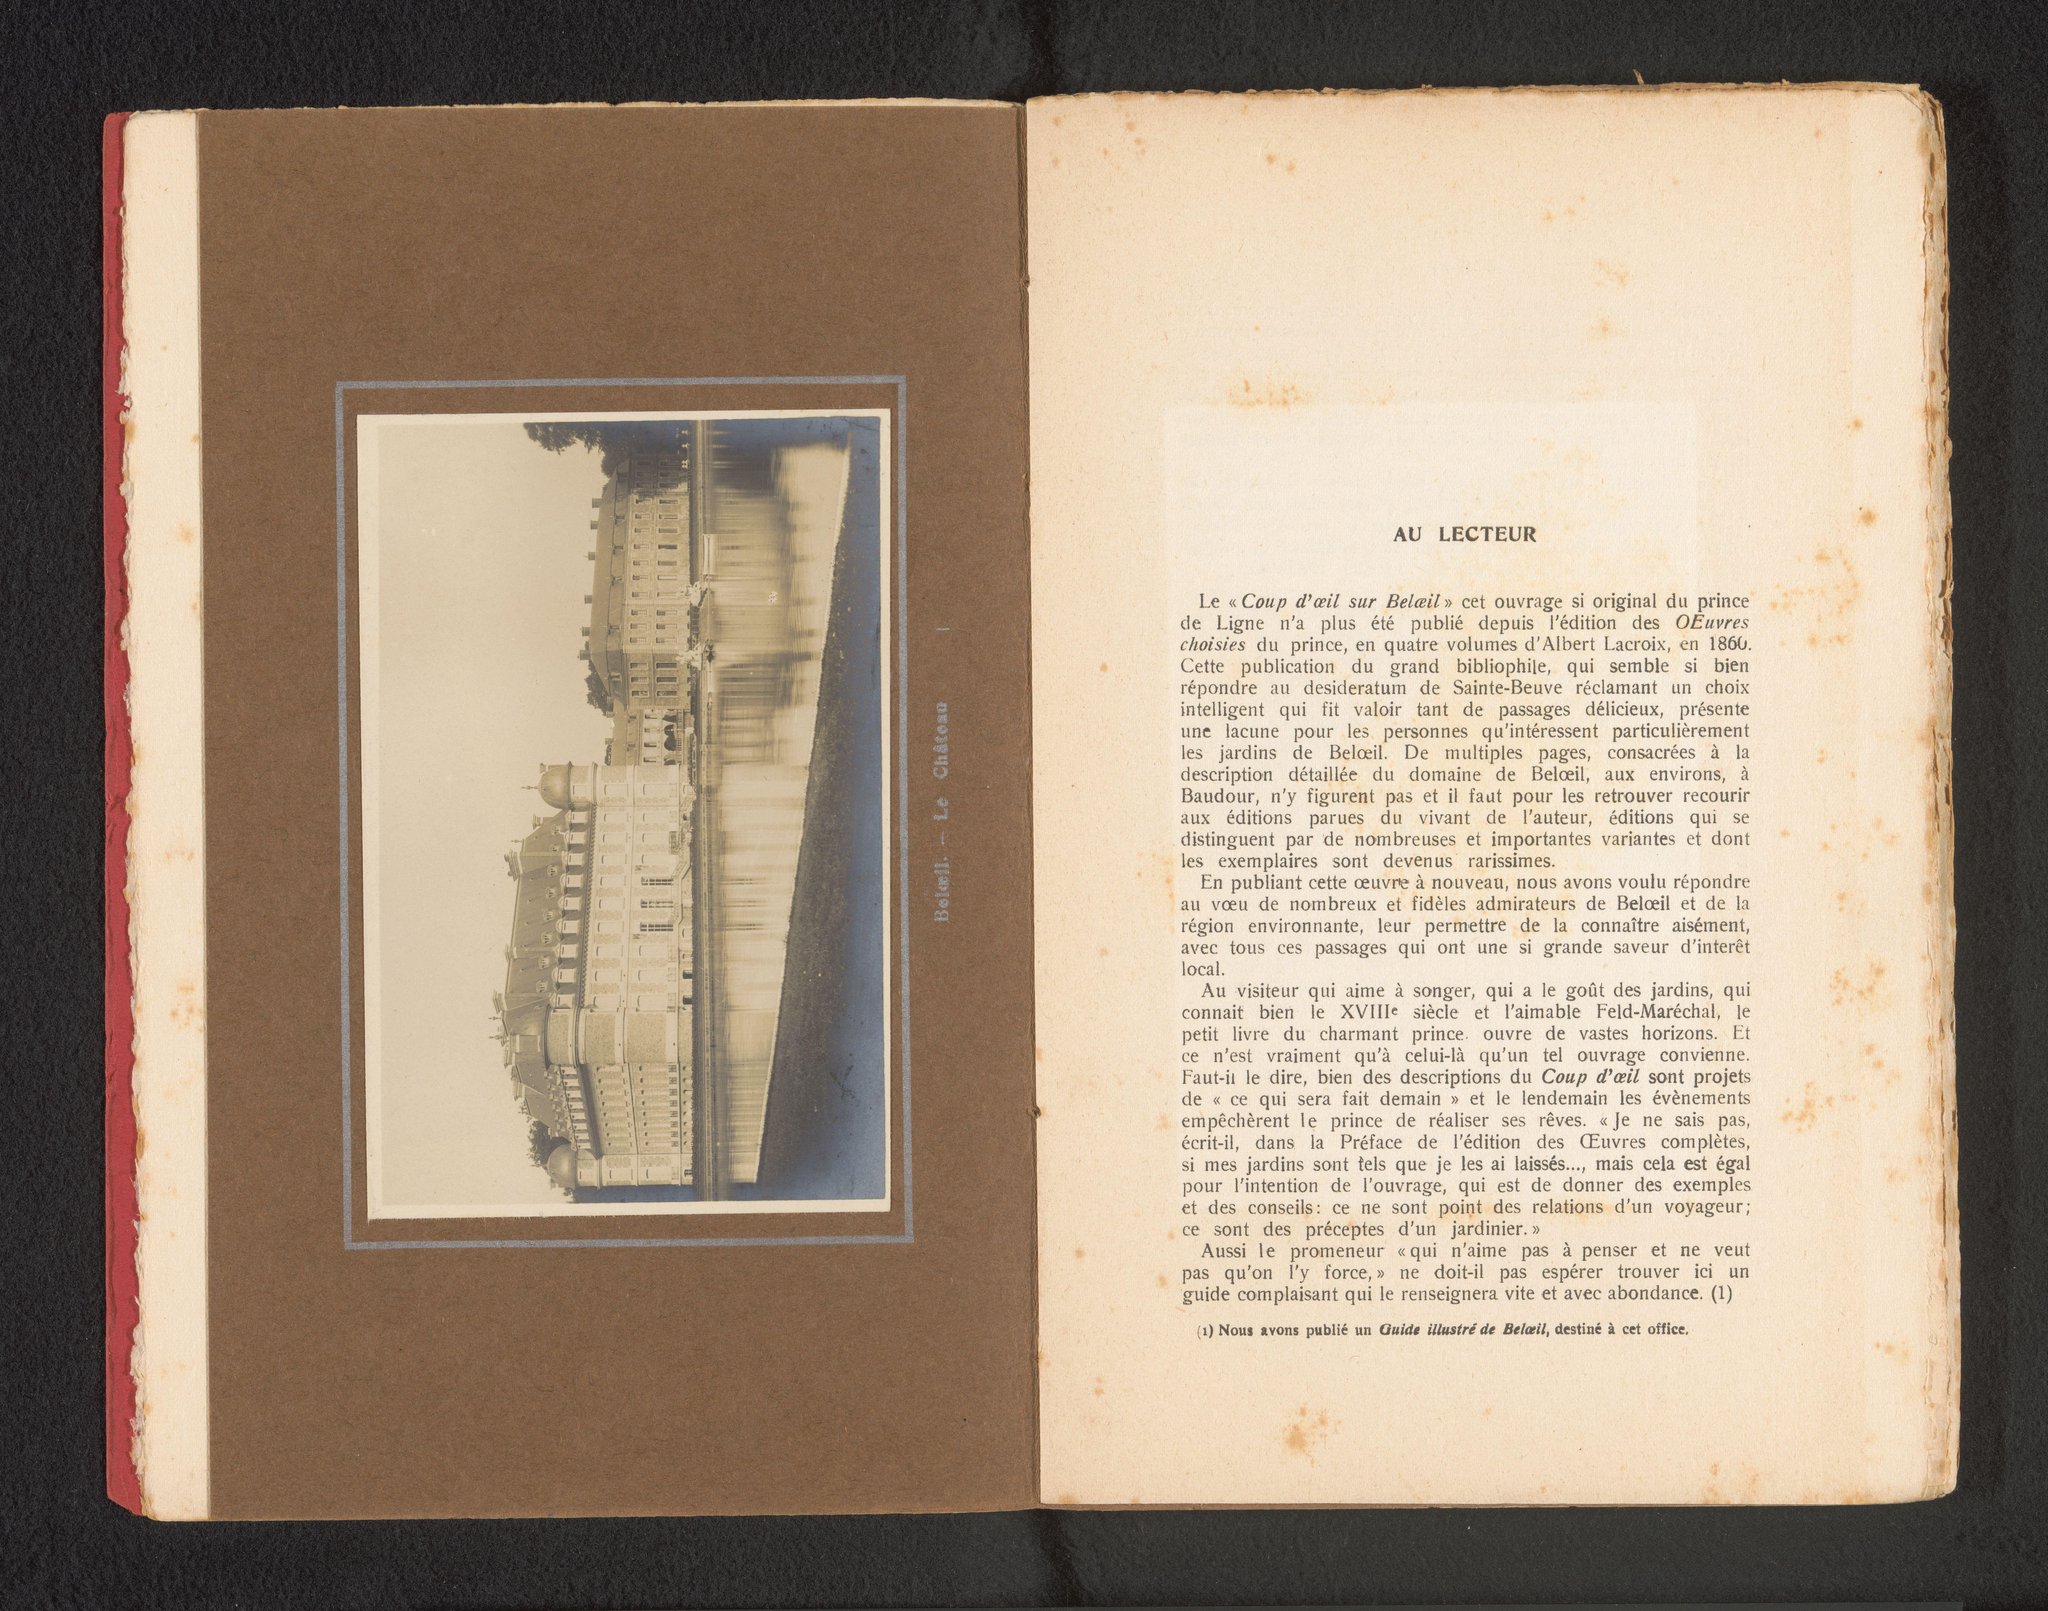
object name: page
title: Beloeil - Le Château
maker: coppin-goisse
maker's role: printer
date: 1904-1909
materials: photographic support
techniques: gelatin silver print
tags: castle